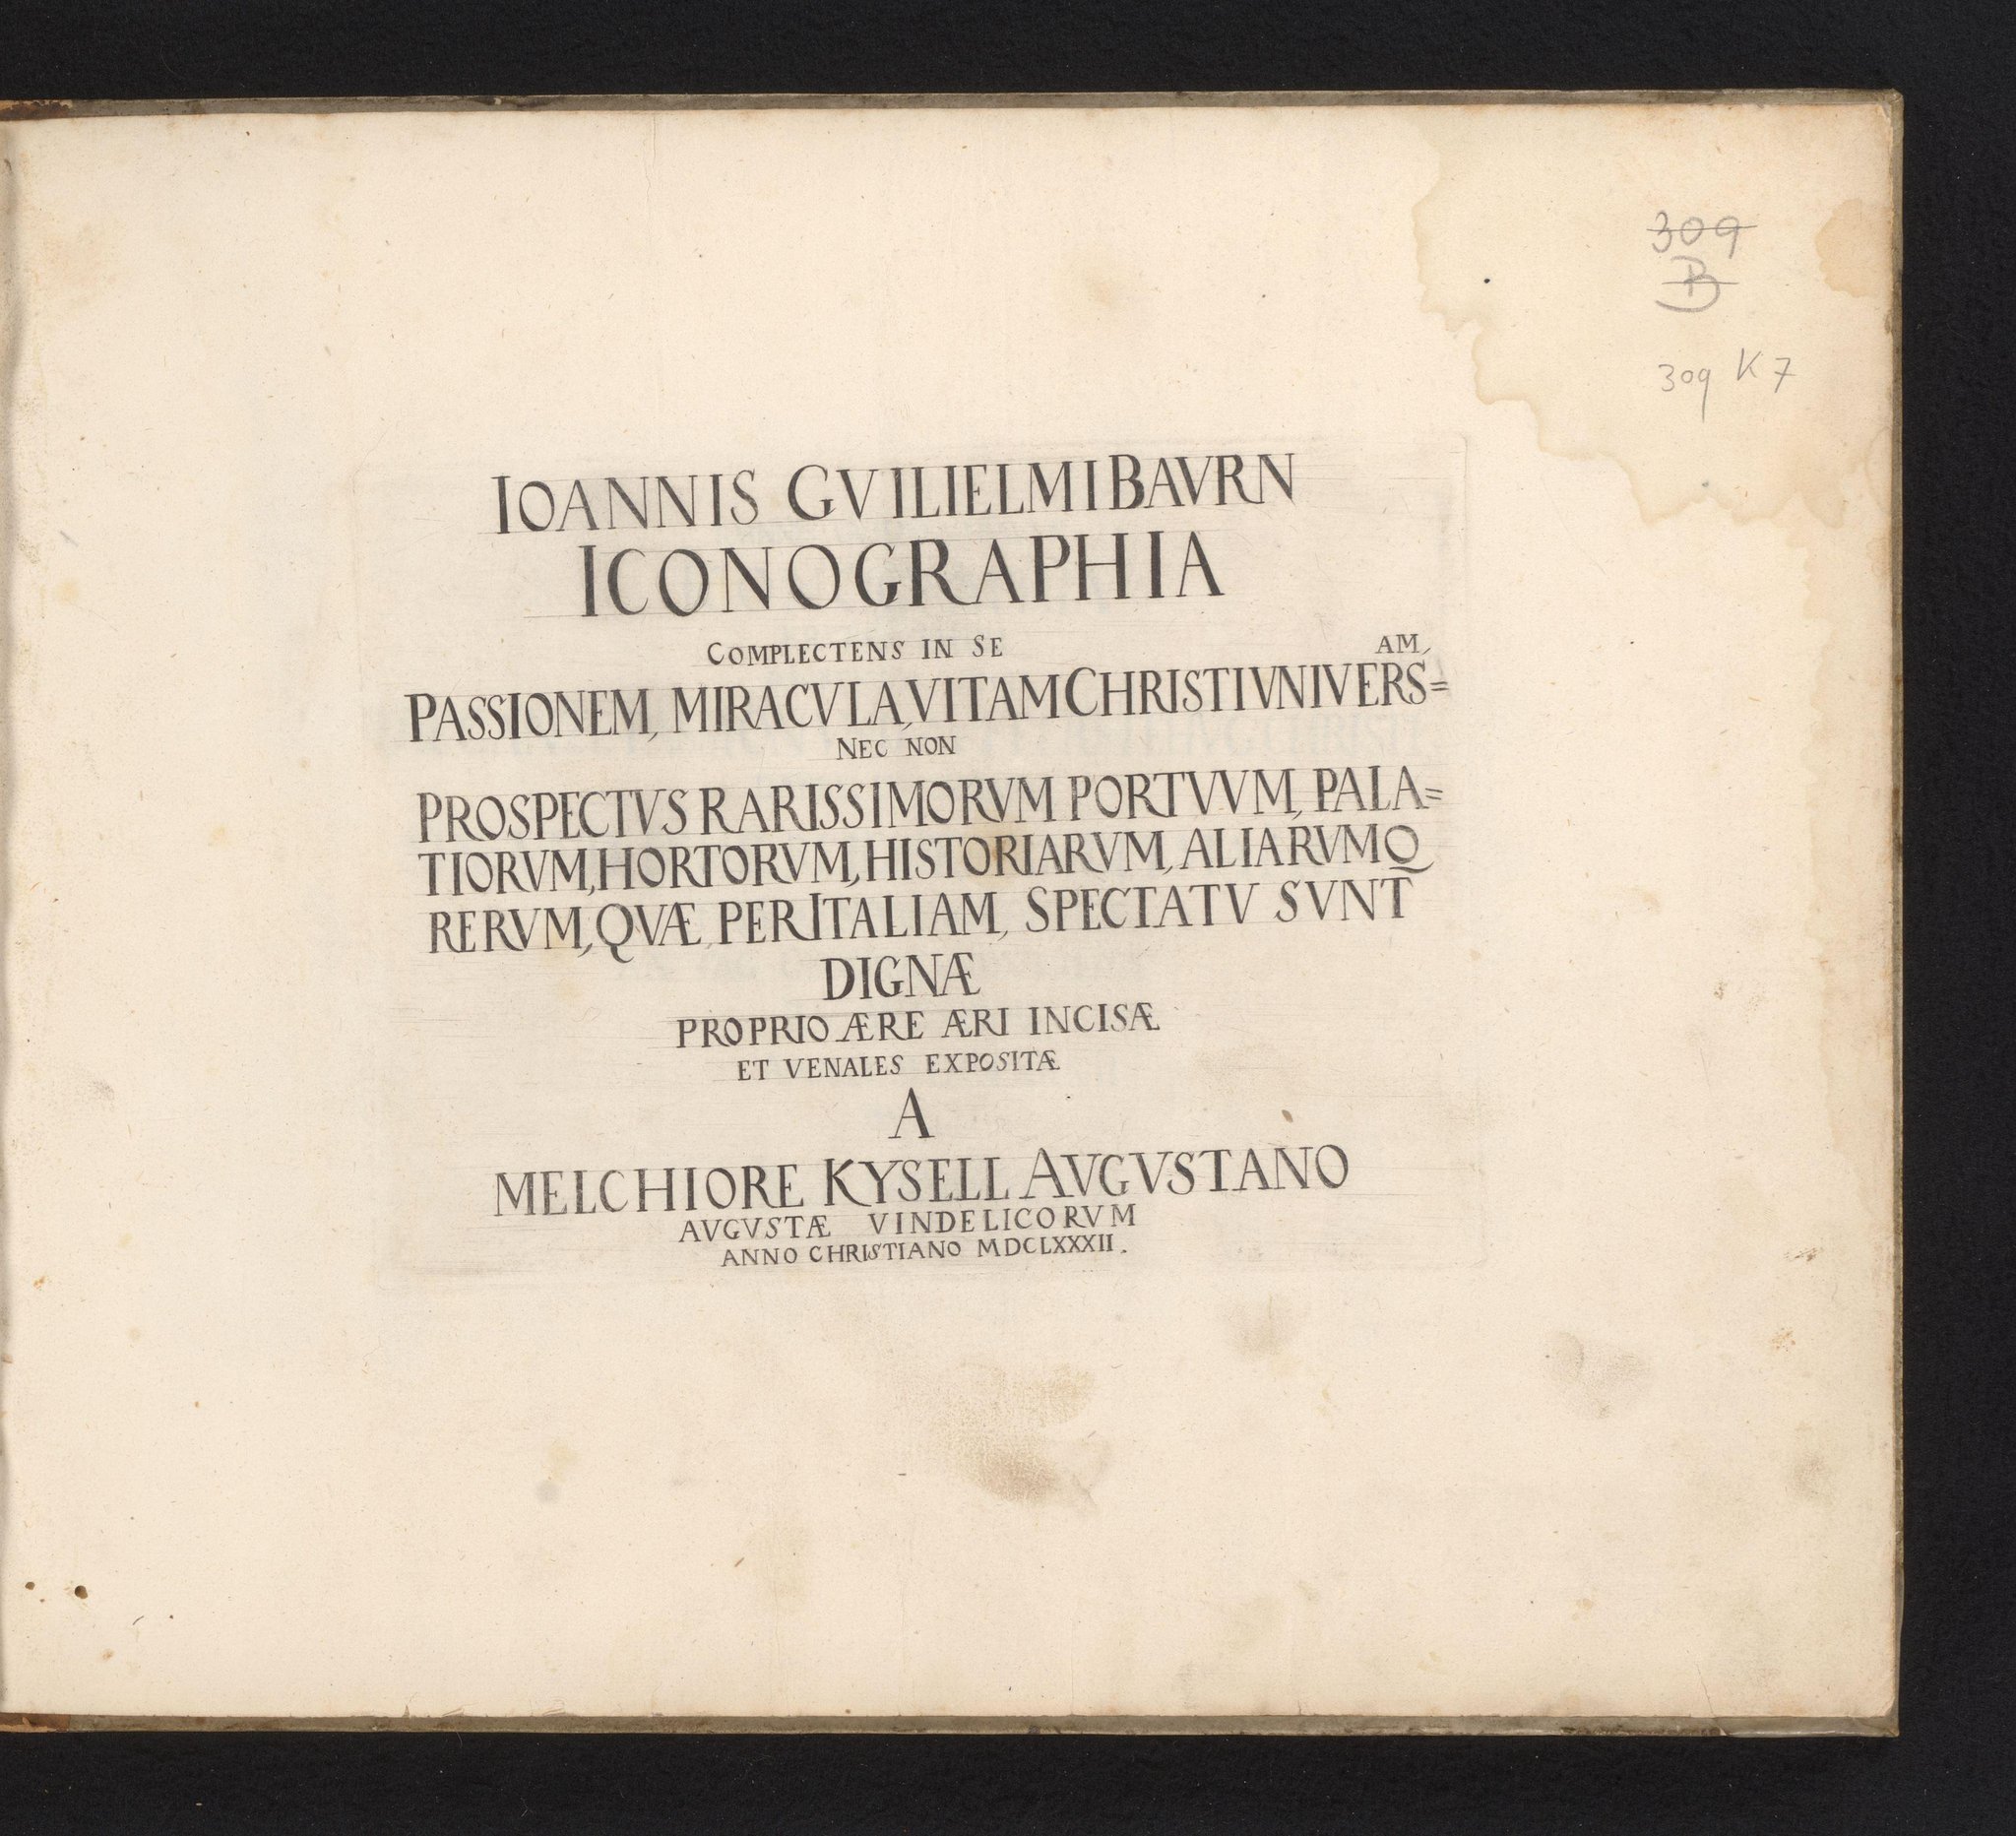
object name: titelprent, frontispice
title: Iconographia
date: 1682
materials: paper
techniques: etching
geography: augsburg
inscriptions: collector's mark: Lugt 2228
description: De volledige titel van de eerste band luidt: Ioannis Guilielmi Baurn Iconographia complectens in se Passionem, Miracula, Vitam Christi Universam, nec non Prospectus rarissimorum portuum, palatiorum, hortorum, historiarum, aliarumq rerum, quae, per Italiam, spectatu sunt dignae, proprio aere aeri incisae et venales expositae, a Melchiore Kysell Augustano Augustae Vindelicorum anno Christiano MDCLXXXII.